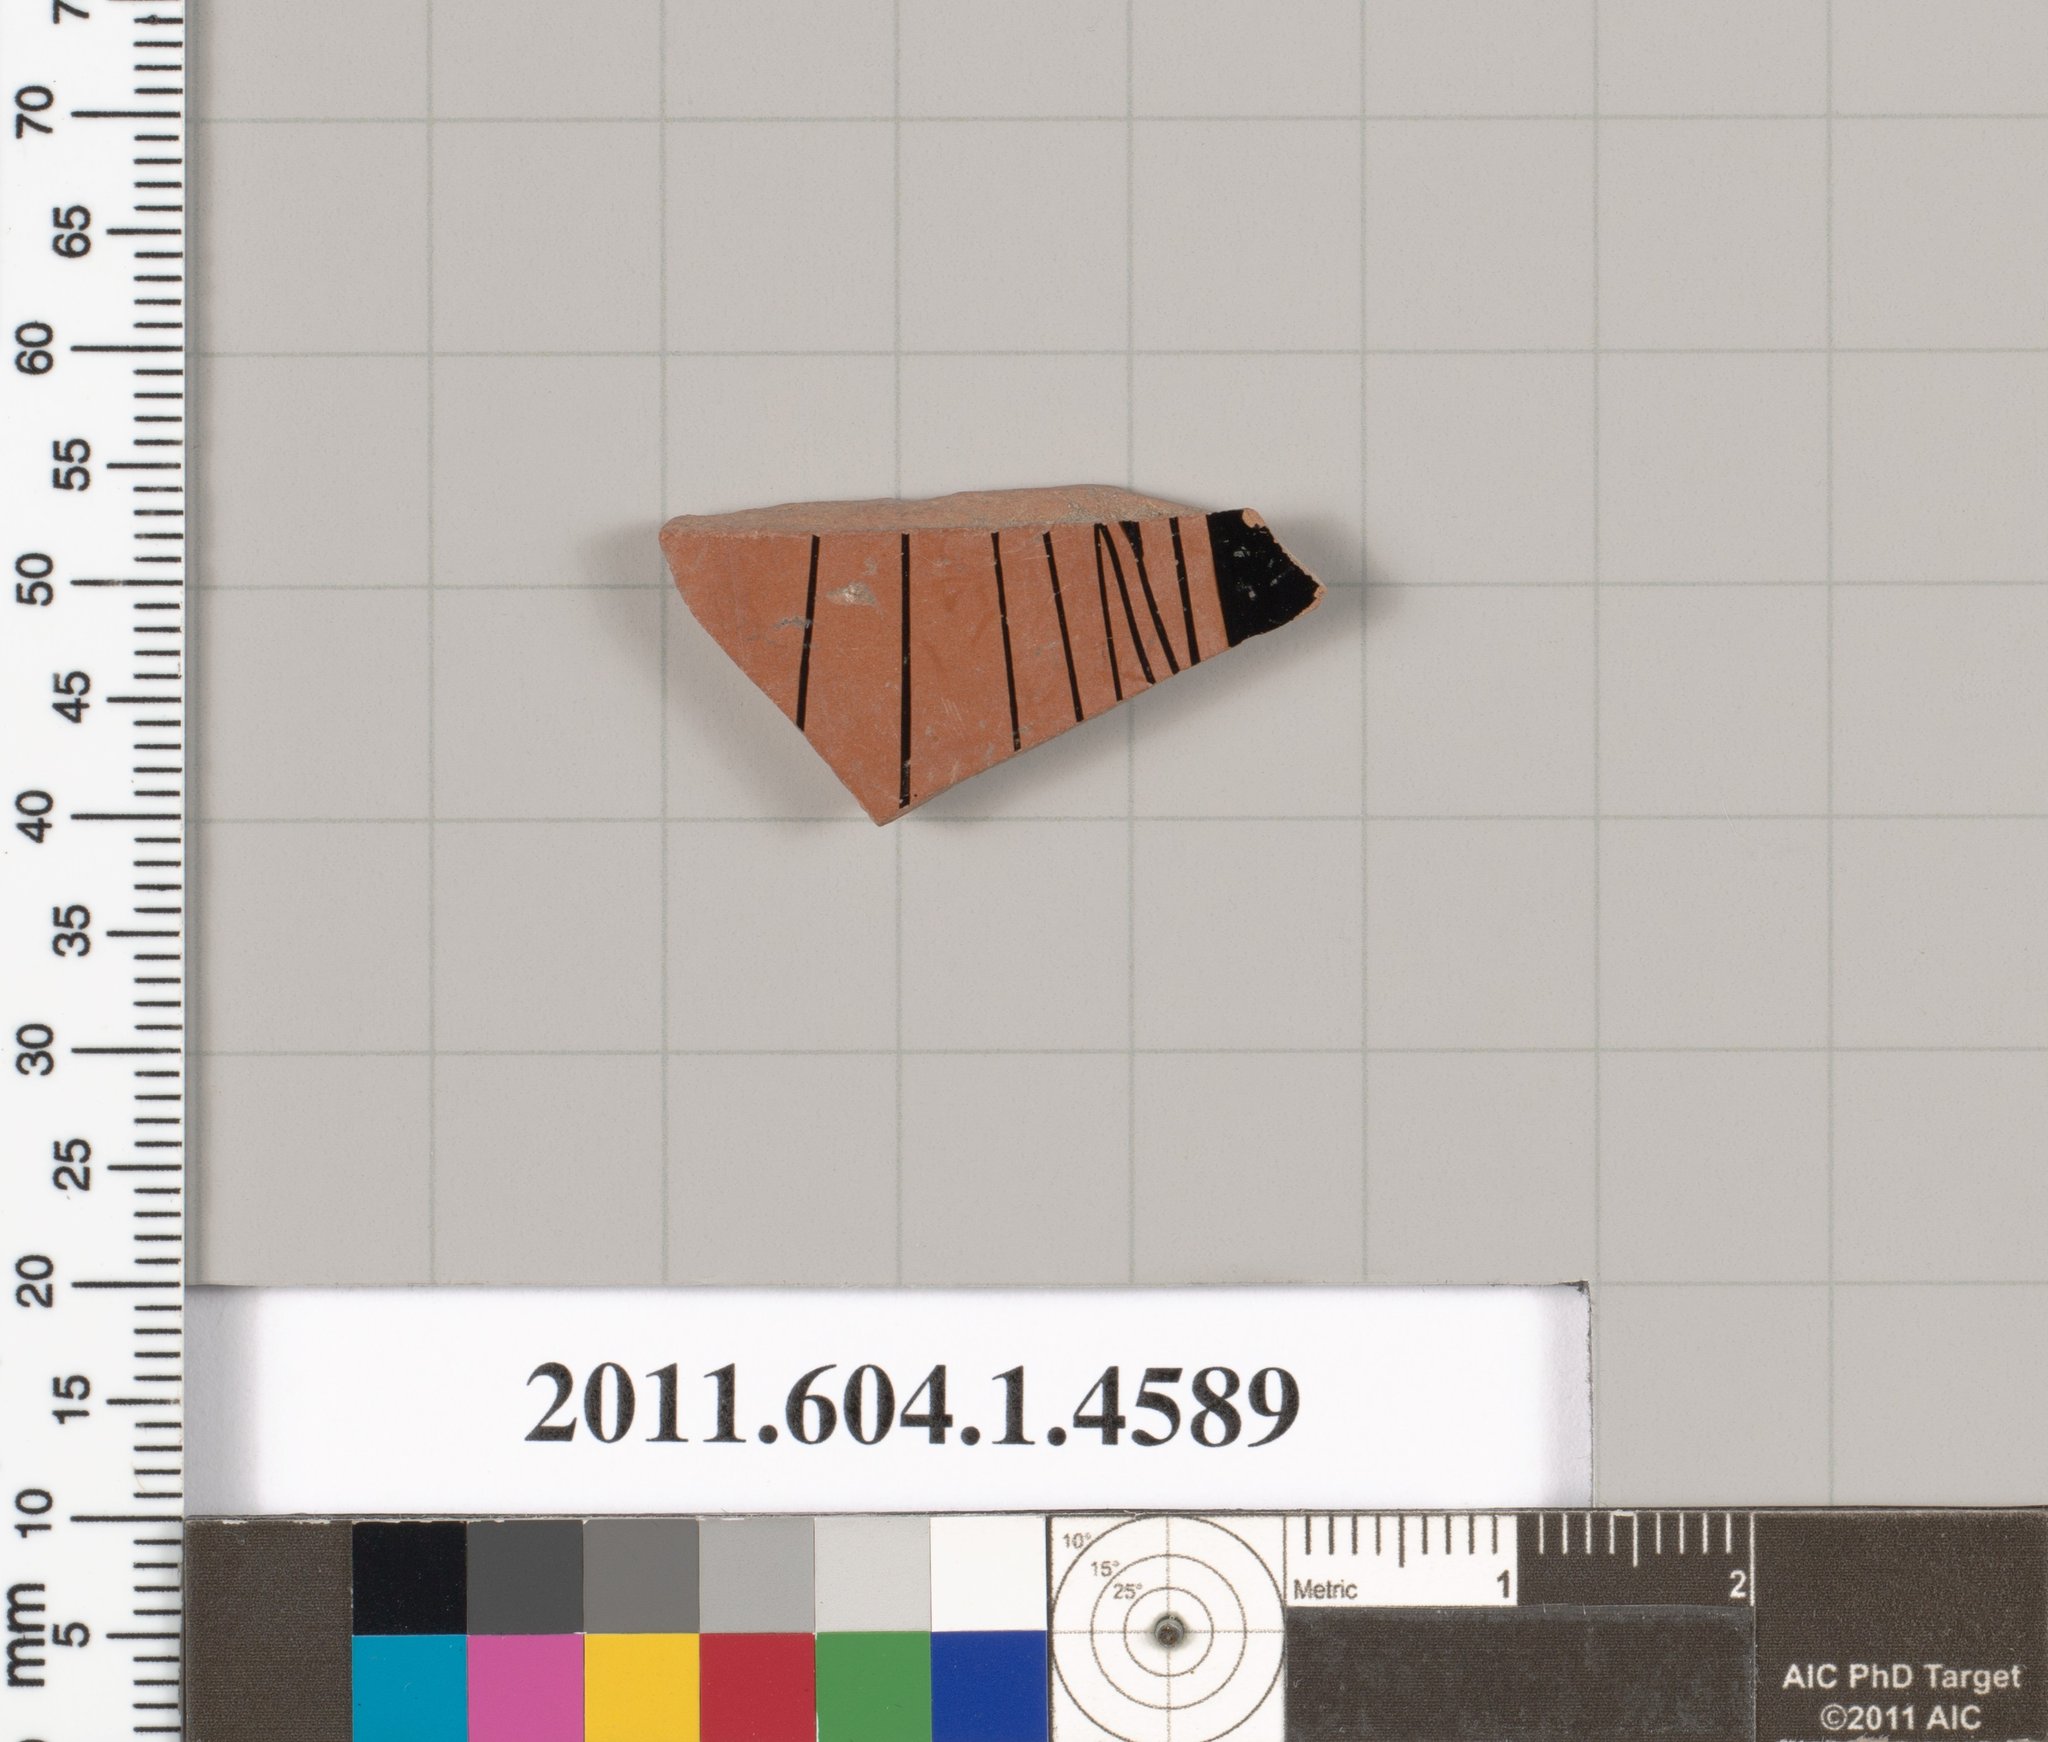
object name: kylix fragment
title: Terracotta fragment of a kylix (drinking cup)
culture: greek, attic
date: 500-480 BCE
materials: terracotta